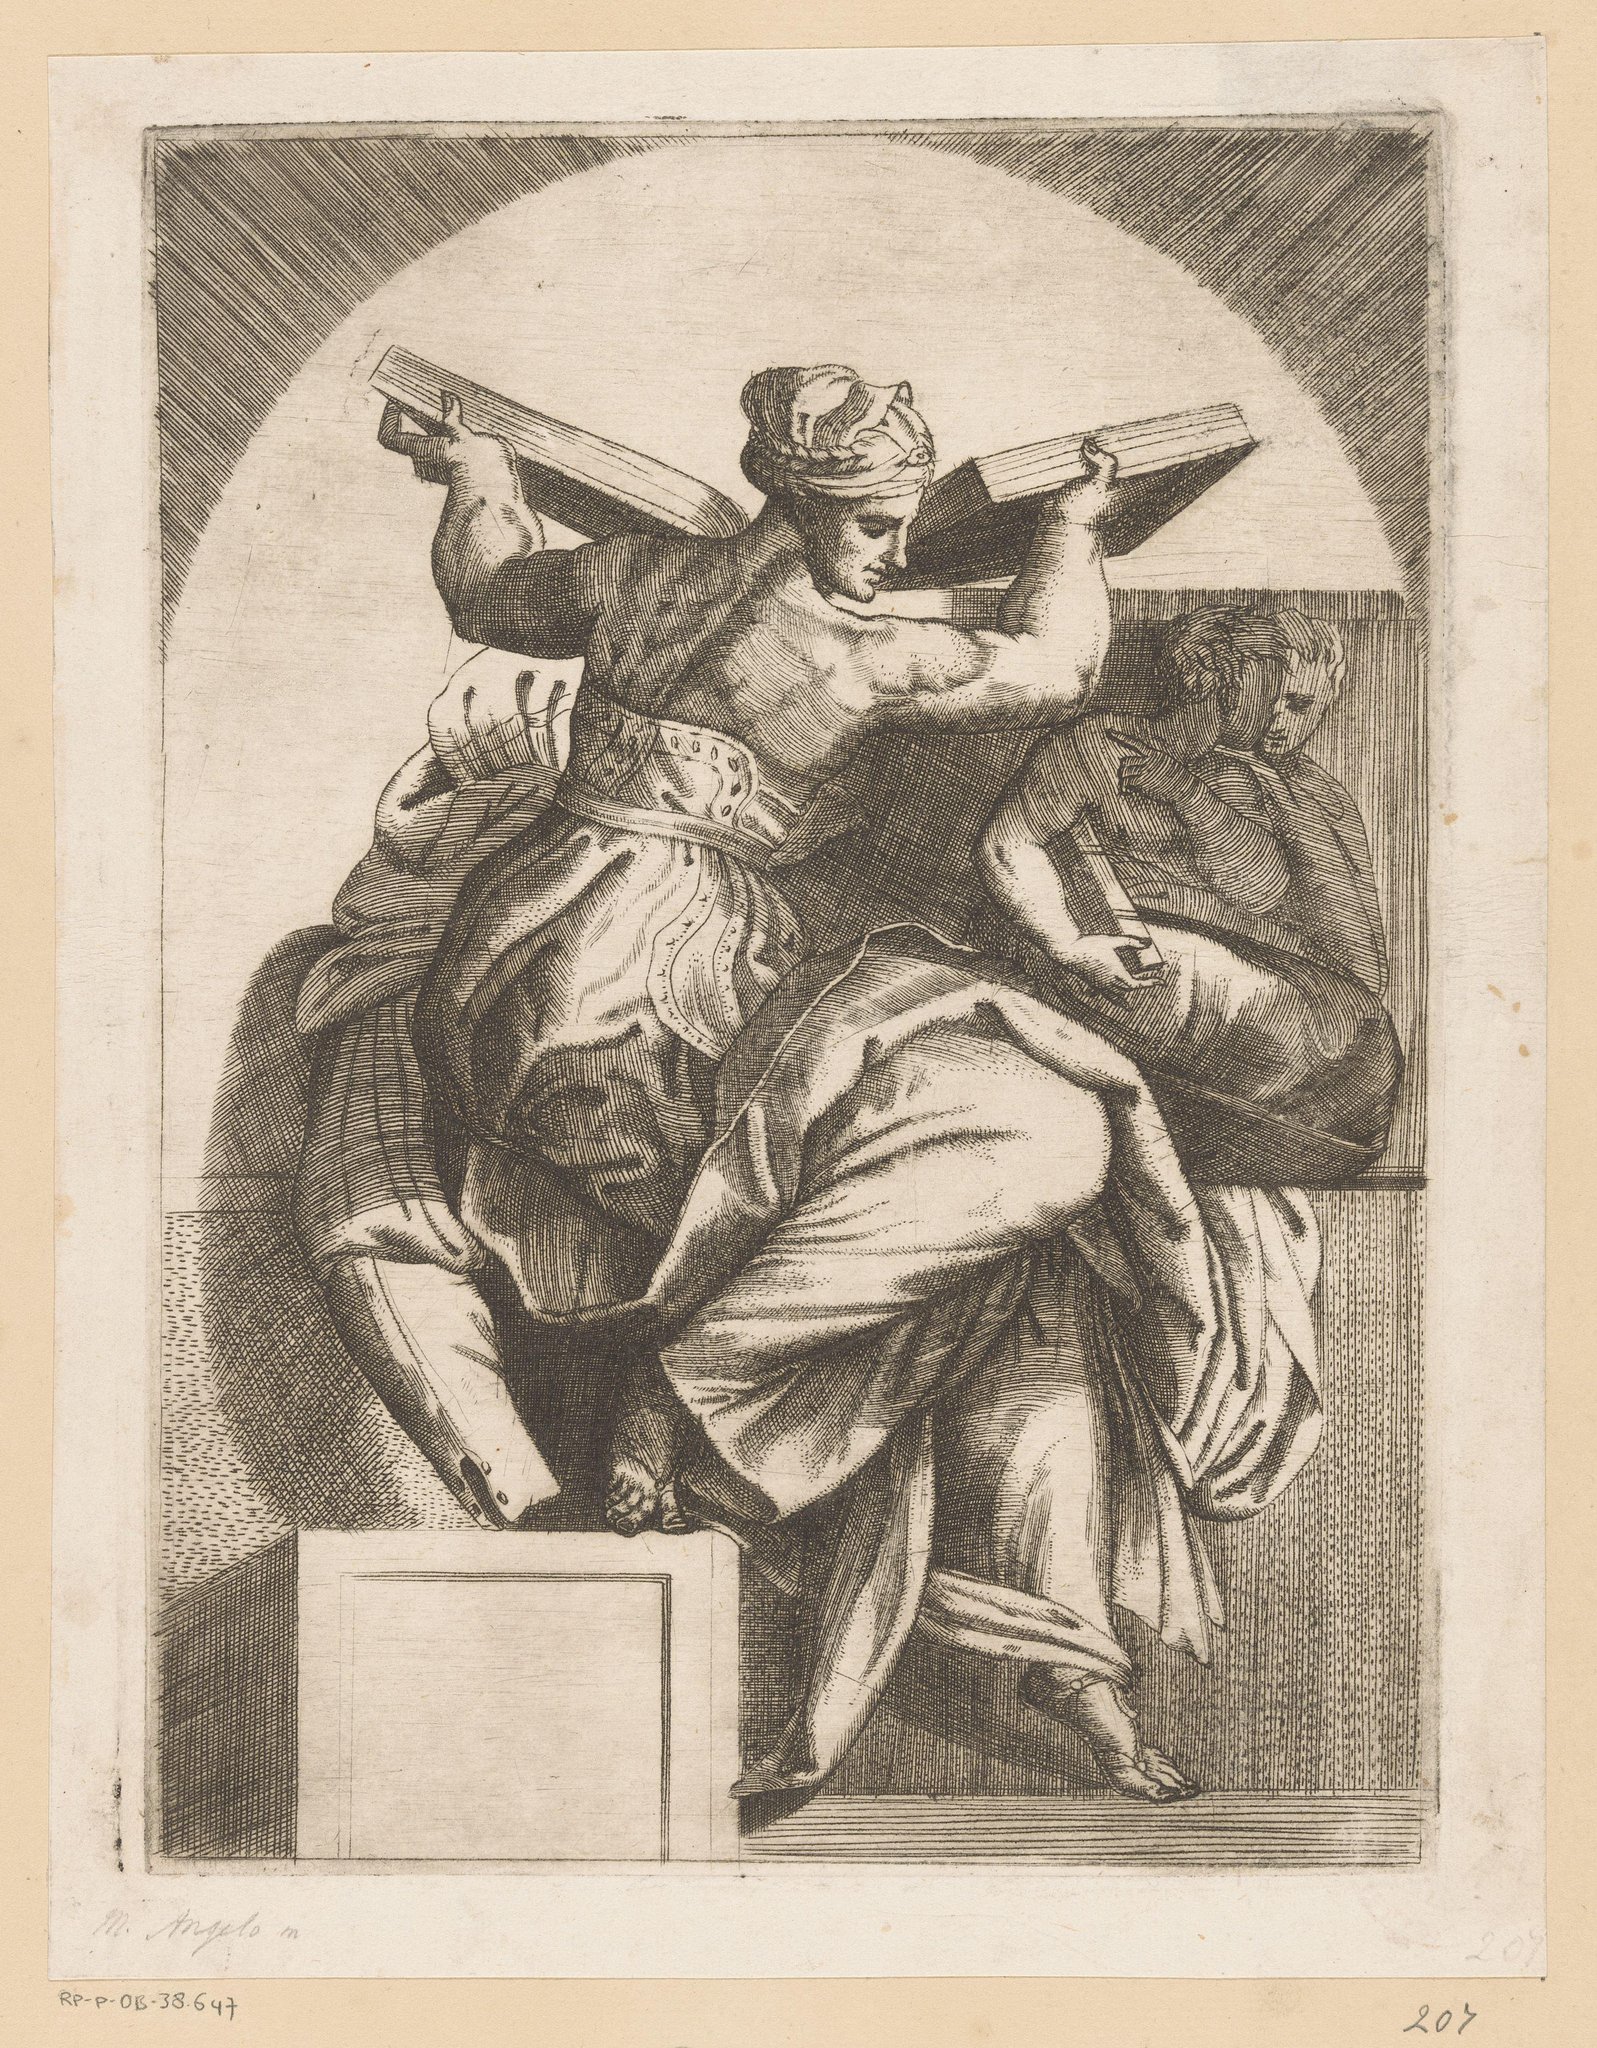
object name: print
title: Libische Sibille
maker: Anonymous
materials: paper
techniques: engraving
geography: italy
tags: sibyls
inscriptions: collector's mark: Lugt 240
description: De Libische Sibille, zittend en naar rechts gedraaid. Achter haar een groot boek dat zij met beide handen omhoog tilt. Rechts twee kinderen met een boekrol.